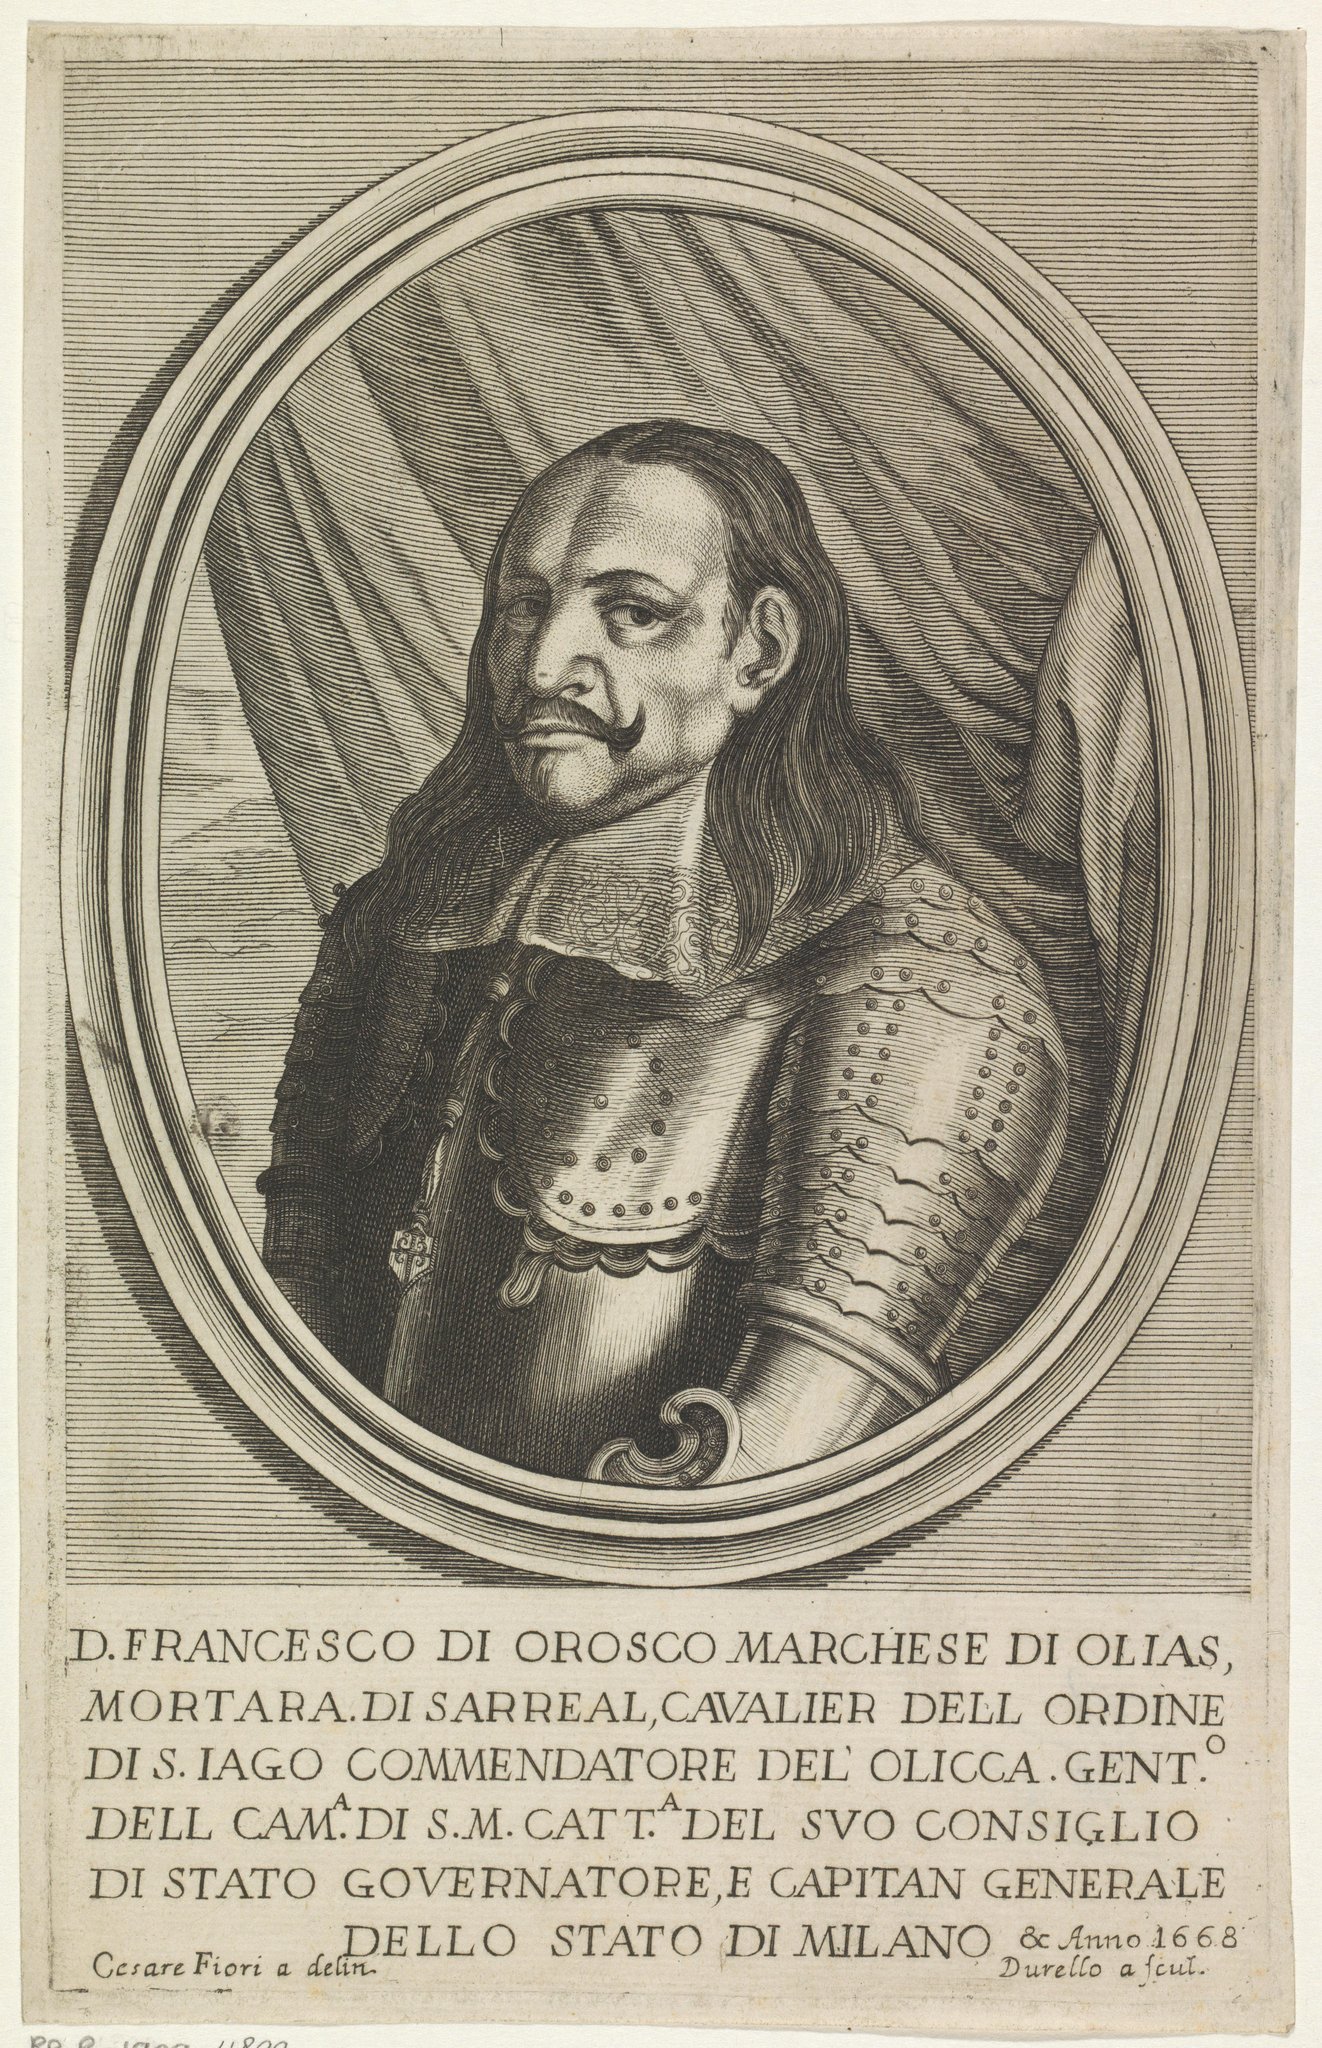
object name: print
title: Portret van Francisco de Orozco, markies van Mortara, Olias en San Reale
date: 1668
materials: paper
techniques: engraving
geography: italy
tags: historical persons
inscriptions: collector's mark: Lugt 2228